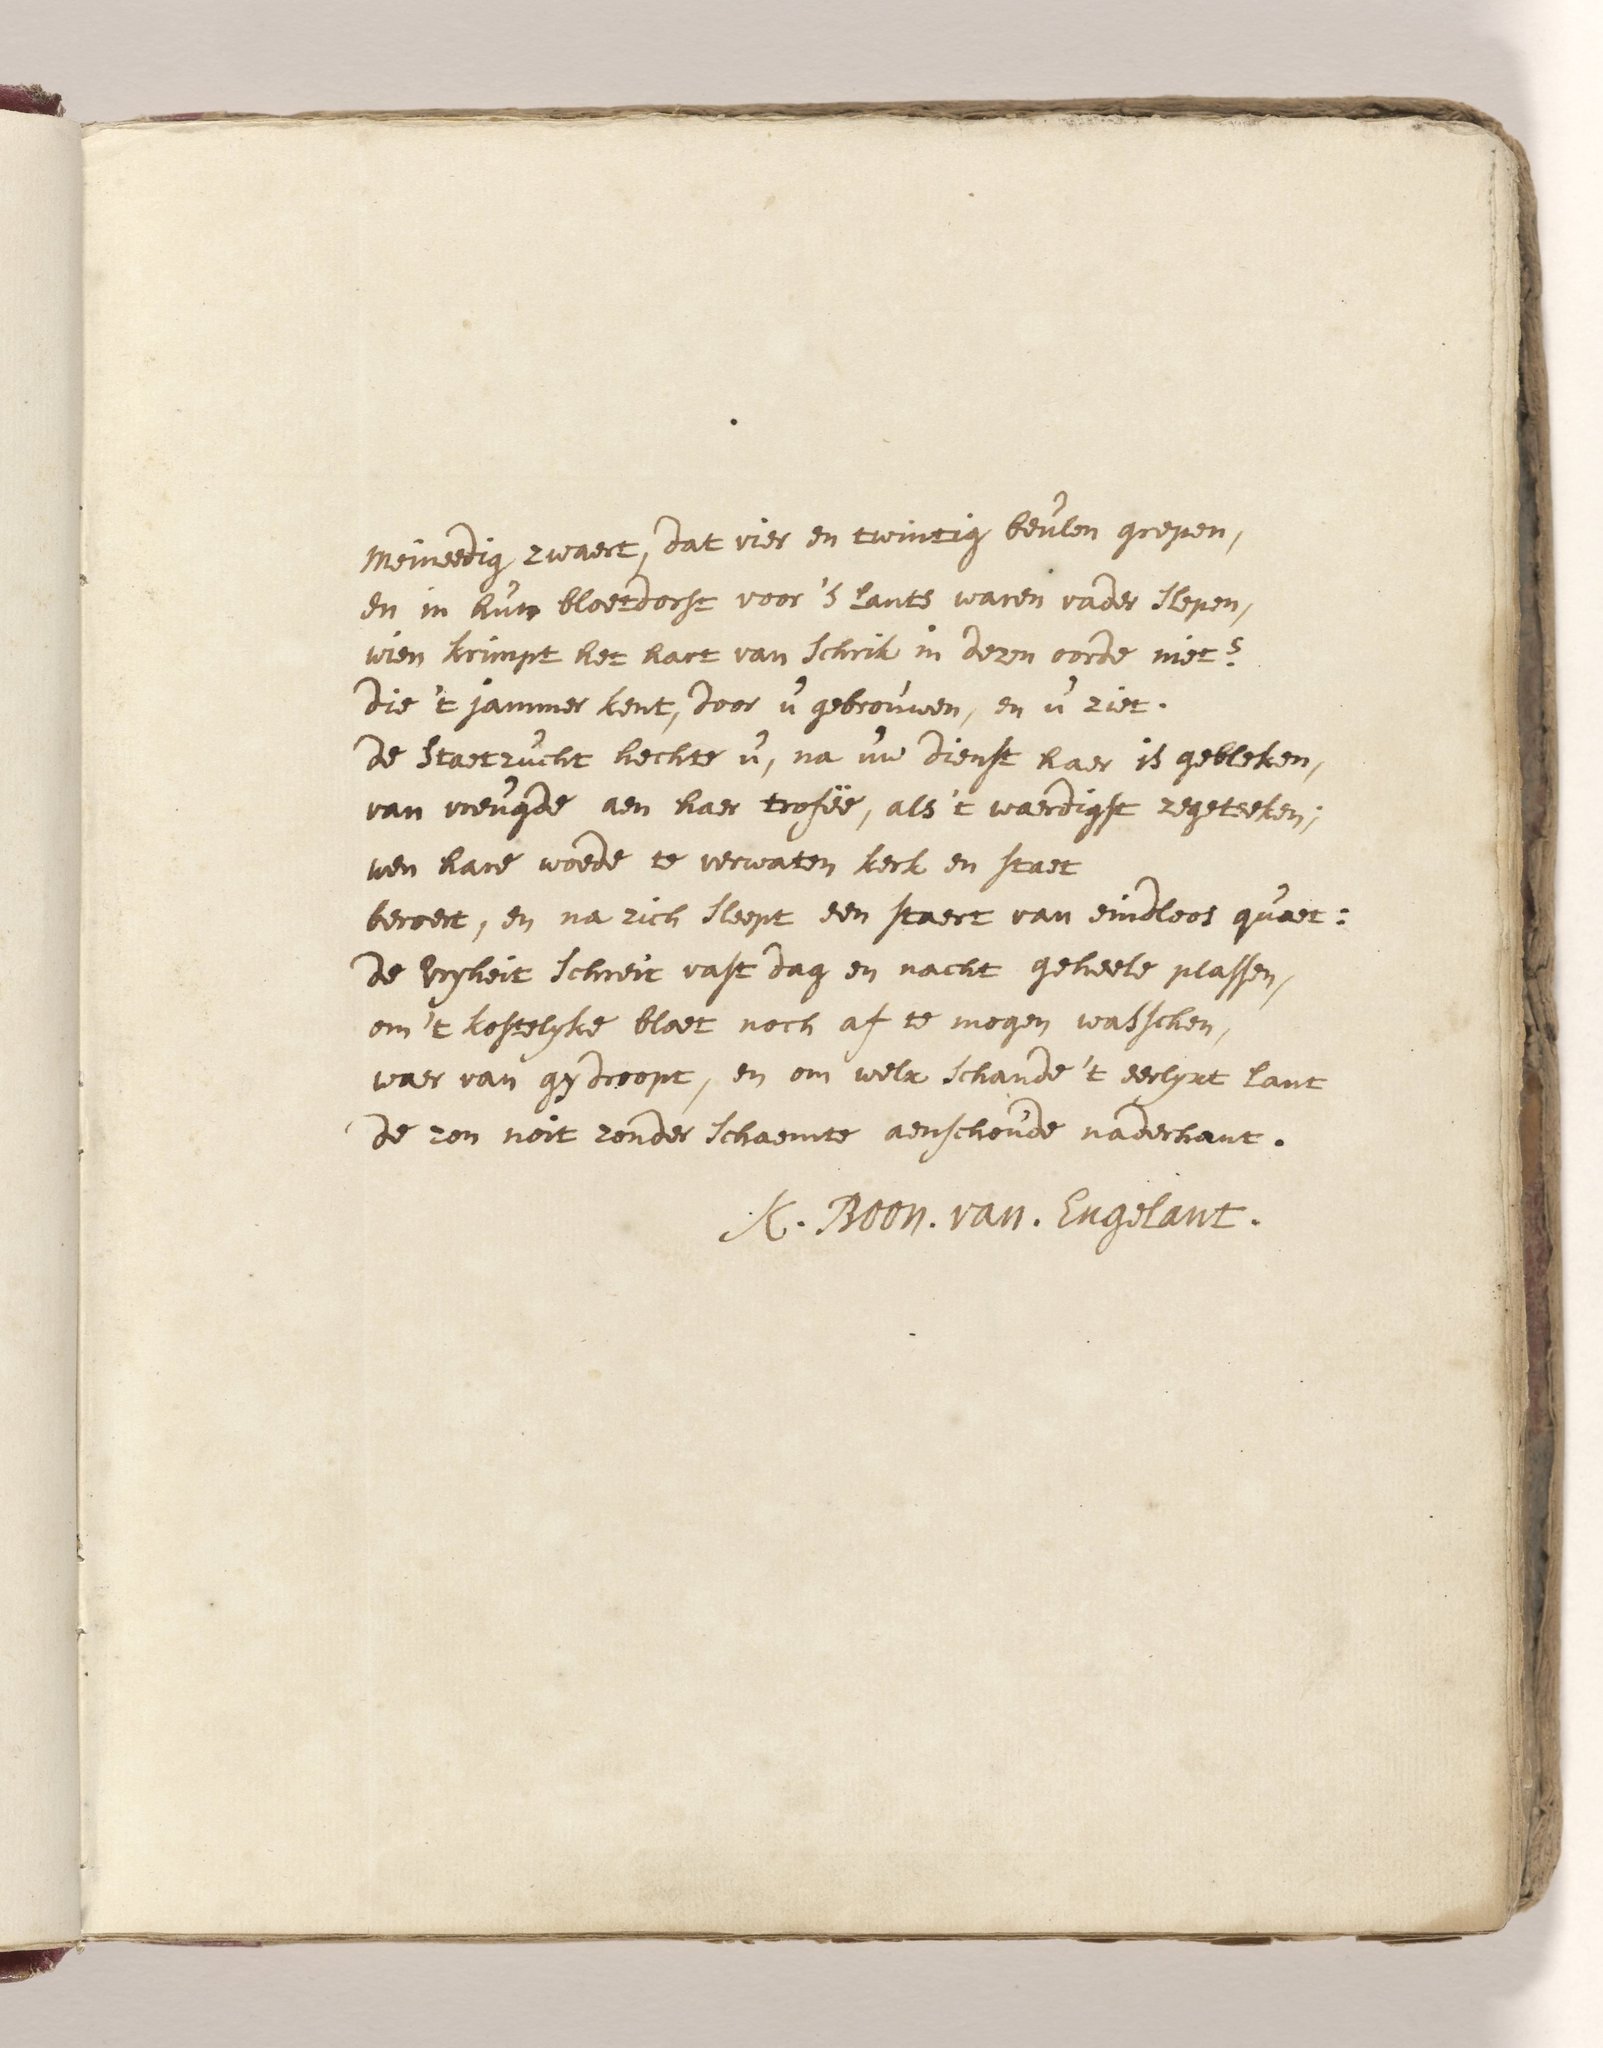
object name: manuscript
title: Gedicht op het zwaard waarmee Johan van Oldenbarnevelt in 1619 zou zijn onthoofd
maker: kornelis boon van engelant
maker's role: dichter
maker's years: 1680-1750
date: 1743-1745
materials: ink, paper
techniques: writing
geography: netherlands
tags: the hague, johan van oldenbarnevelt, dordrecht, frans greenwood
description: Vers van Kornelis Boon van Engelant. Onderdeel van het boek met gedichten uit de jaren 1743-1745 op het zwaard waarmee Johan van Oldenbarnevelt in 1619 zou zijn onthoofd. Het zwaard was eigendom van Frans Greenwood.